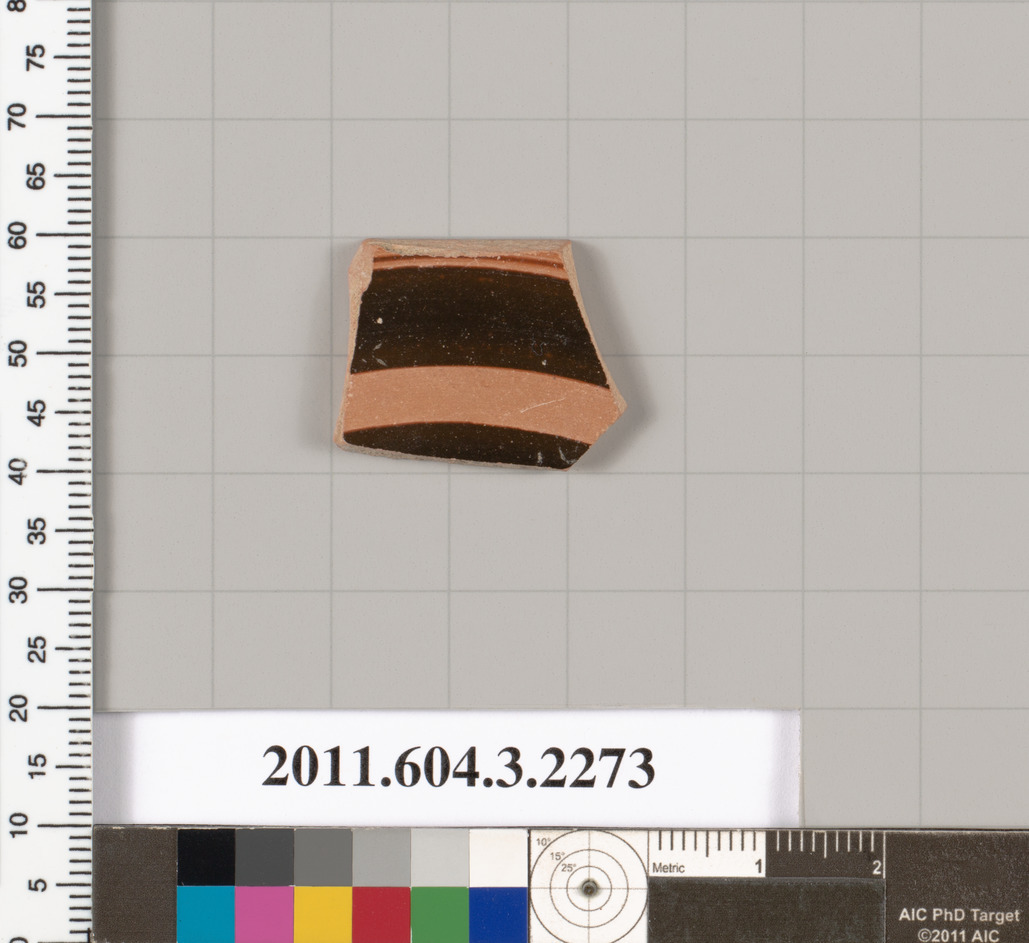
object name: kylix fragment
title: Terracotta fragment of a kylix (drinking cup)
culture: greek, attic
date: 600-401 BCE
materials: terracotta